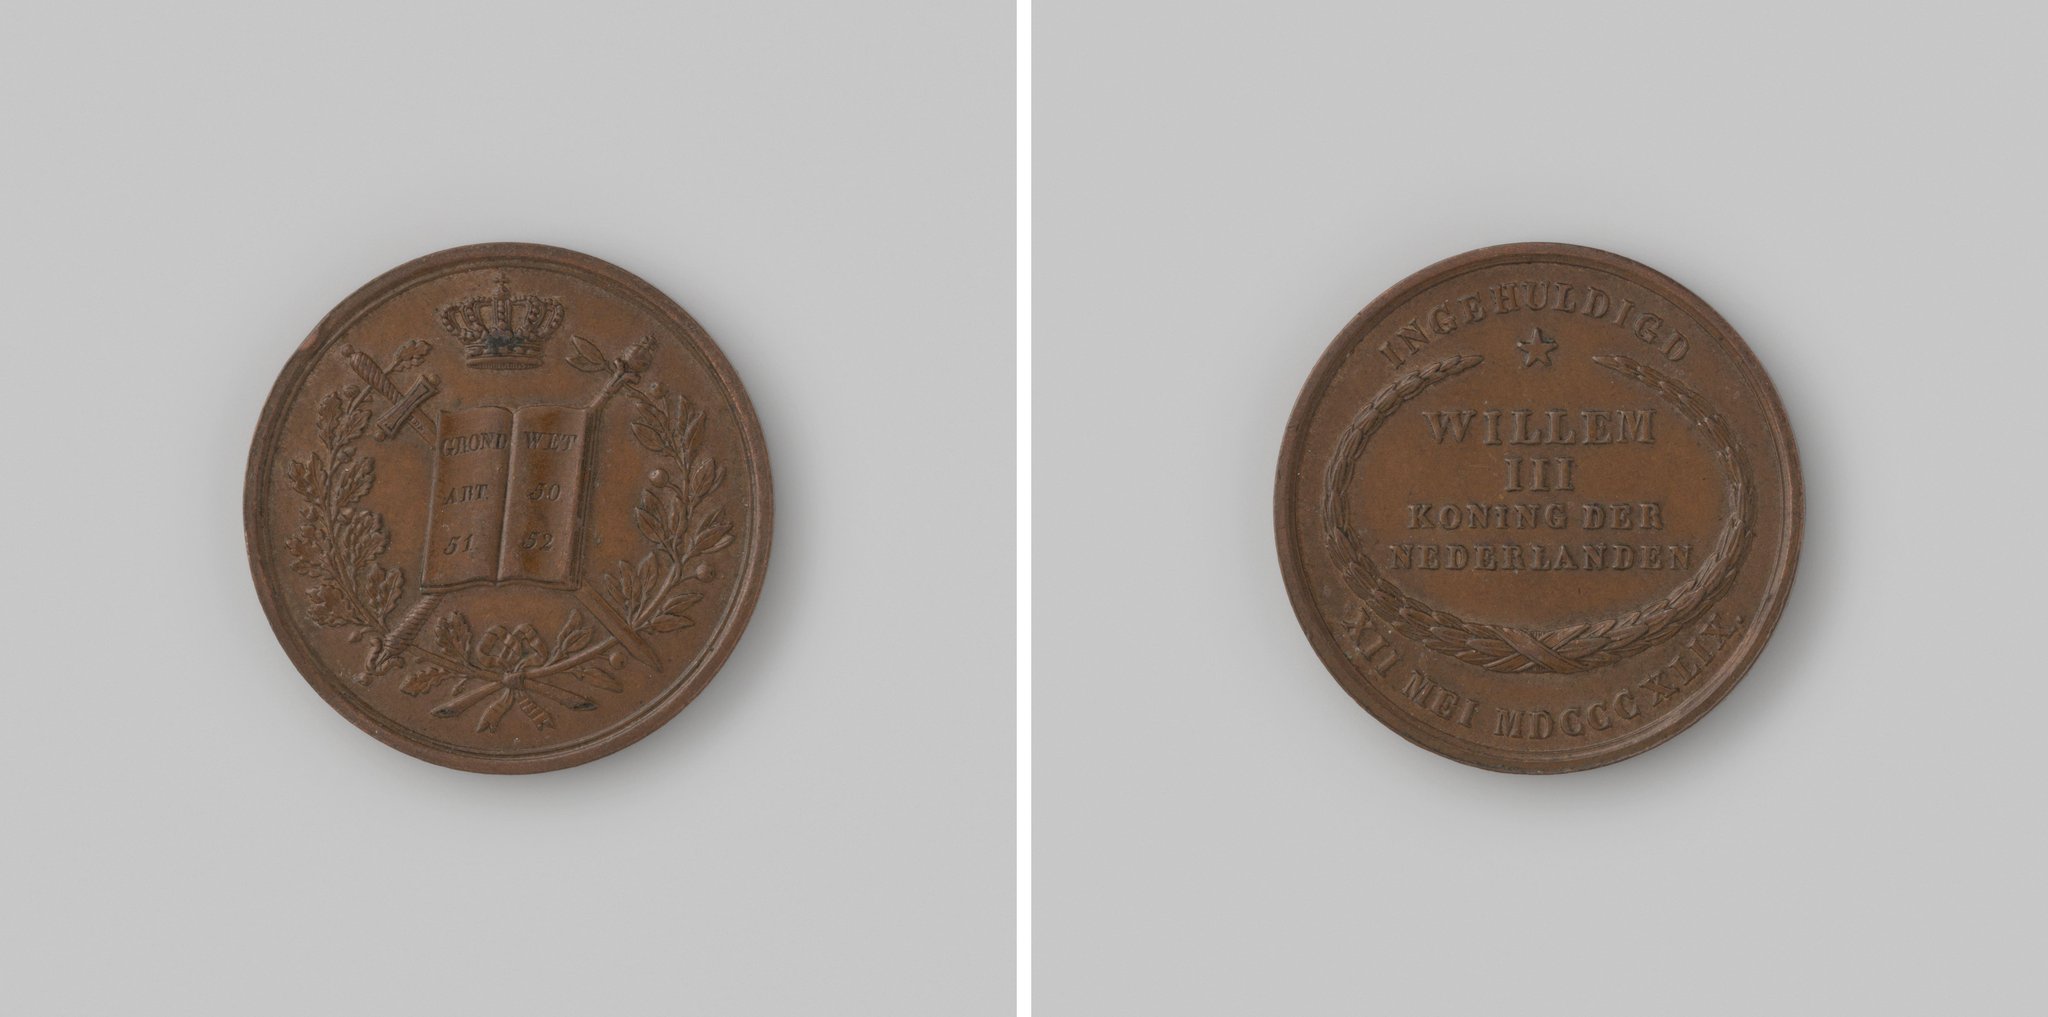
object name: history medal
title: Strooipenning op de inhuldiging van Willem III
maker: Anonymous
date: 1849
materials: bronze